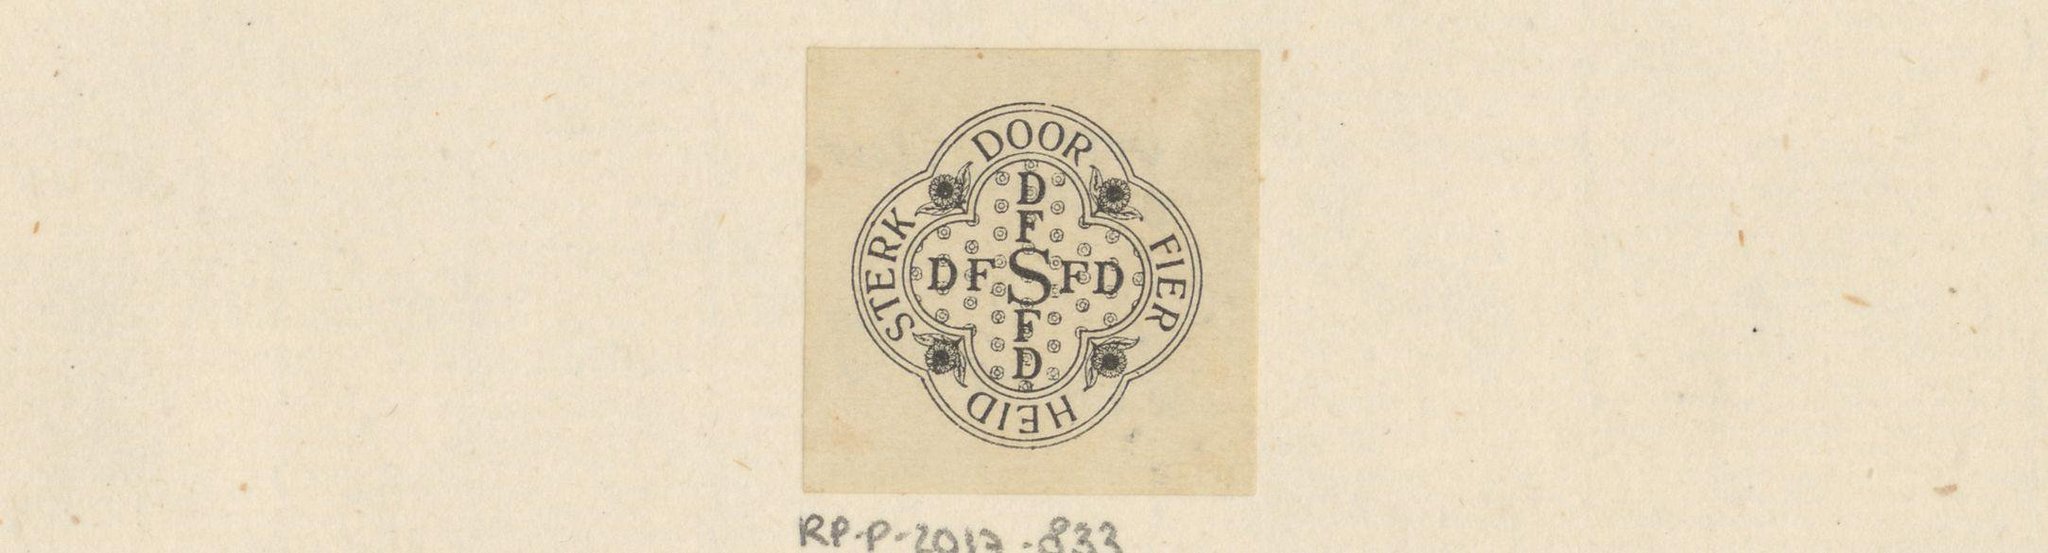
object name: bookplate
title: Ex libris van D.F.S.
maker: Anonymous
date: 1887-1927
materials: paper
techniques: printing block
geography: netherlands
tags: the hague, daniël françois scheurleer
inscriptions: inscription: ‘D.F. Scheurleer / W.v. Konijnenburg’